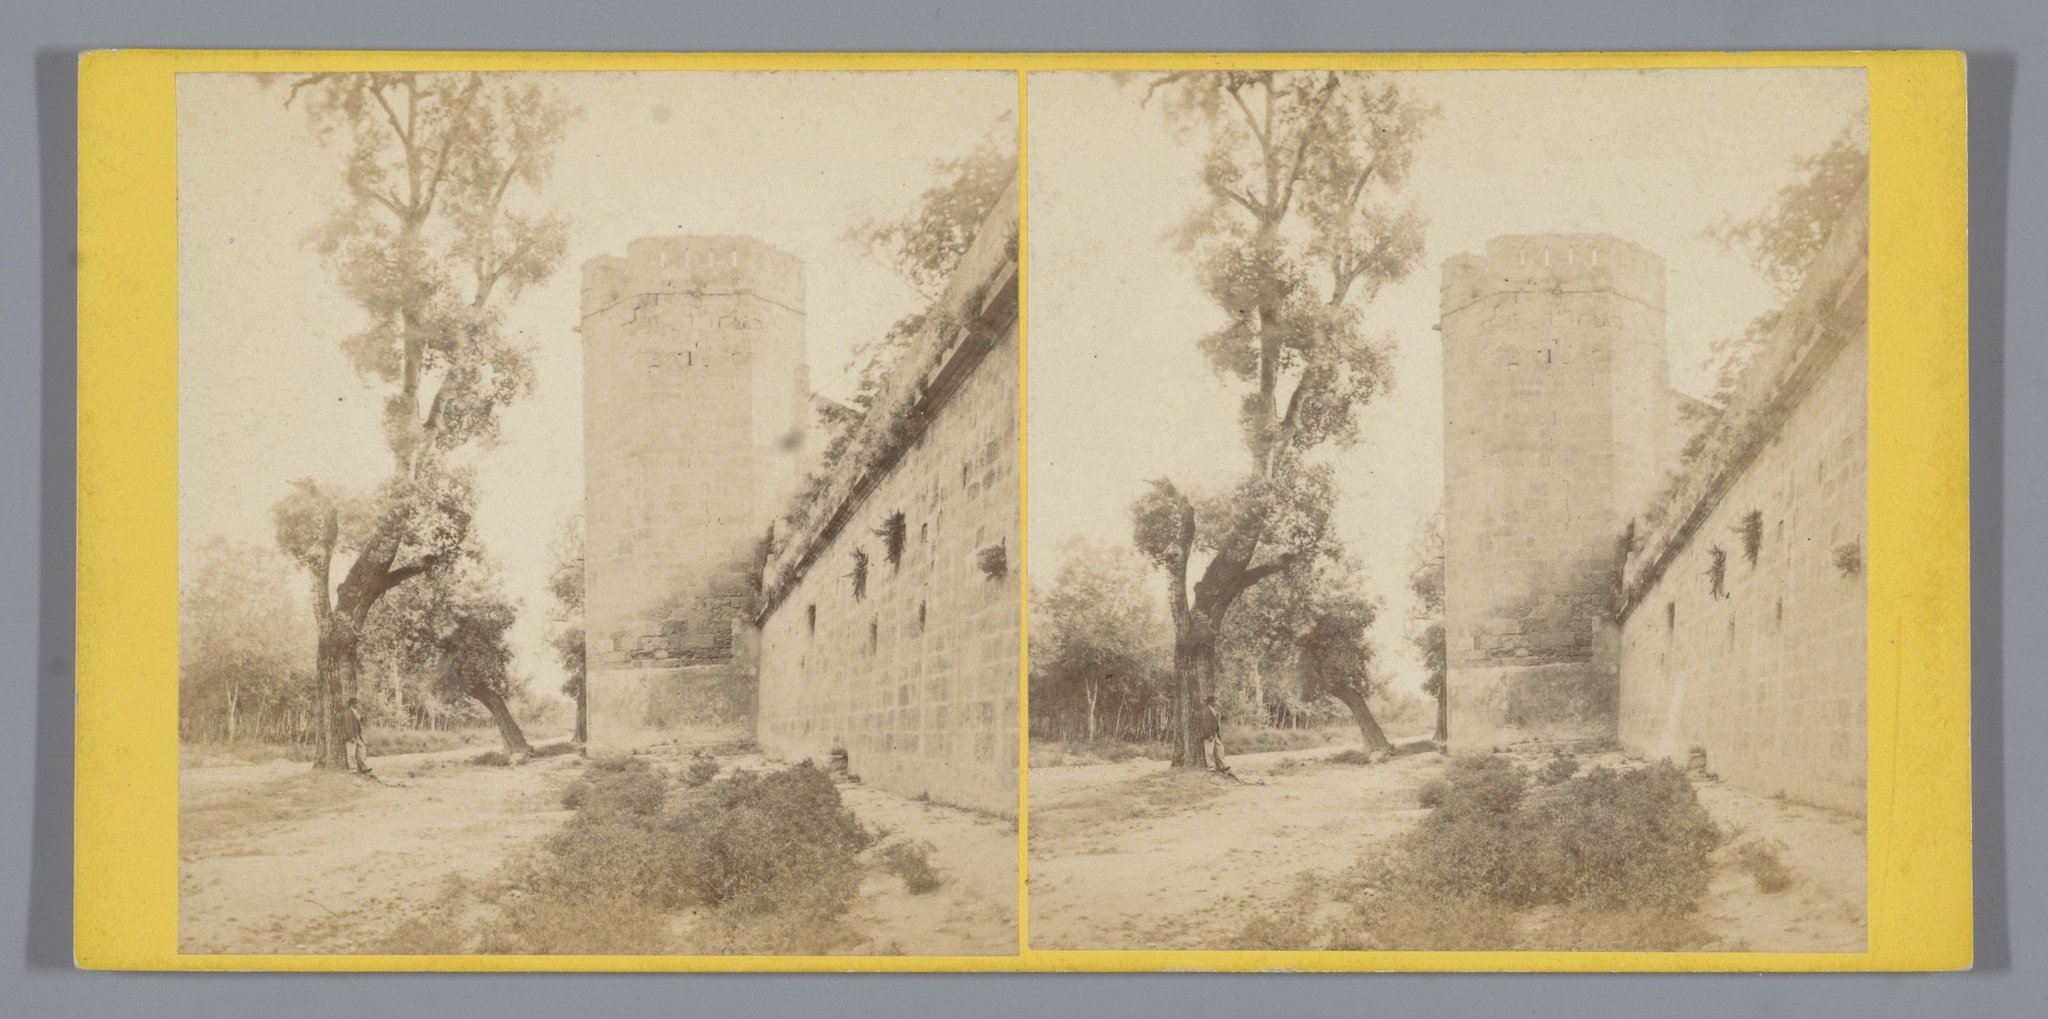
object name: stereograph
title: Cordova - The Caliph's Tower from road.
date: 1860-1880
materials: cardboard, photographic support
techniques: albumen print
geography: london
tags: fortress, tower, clock tower ~ monumental adornment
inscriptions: name: ‘Frank M. Good's Spain’, number: ‘No. 307.’